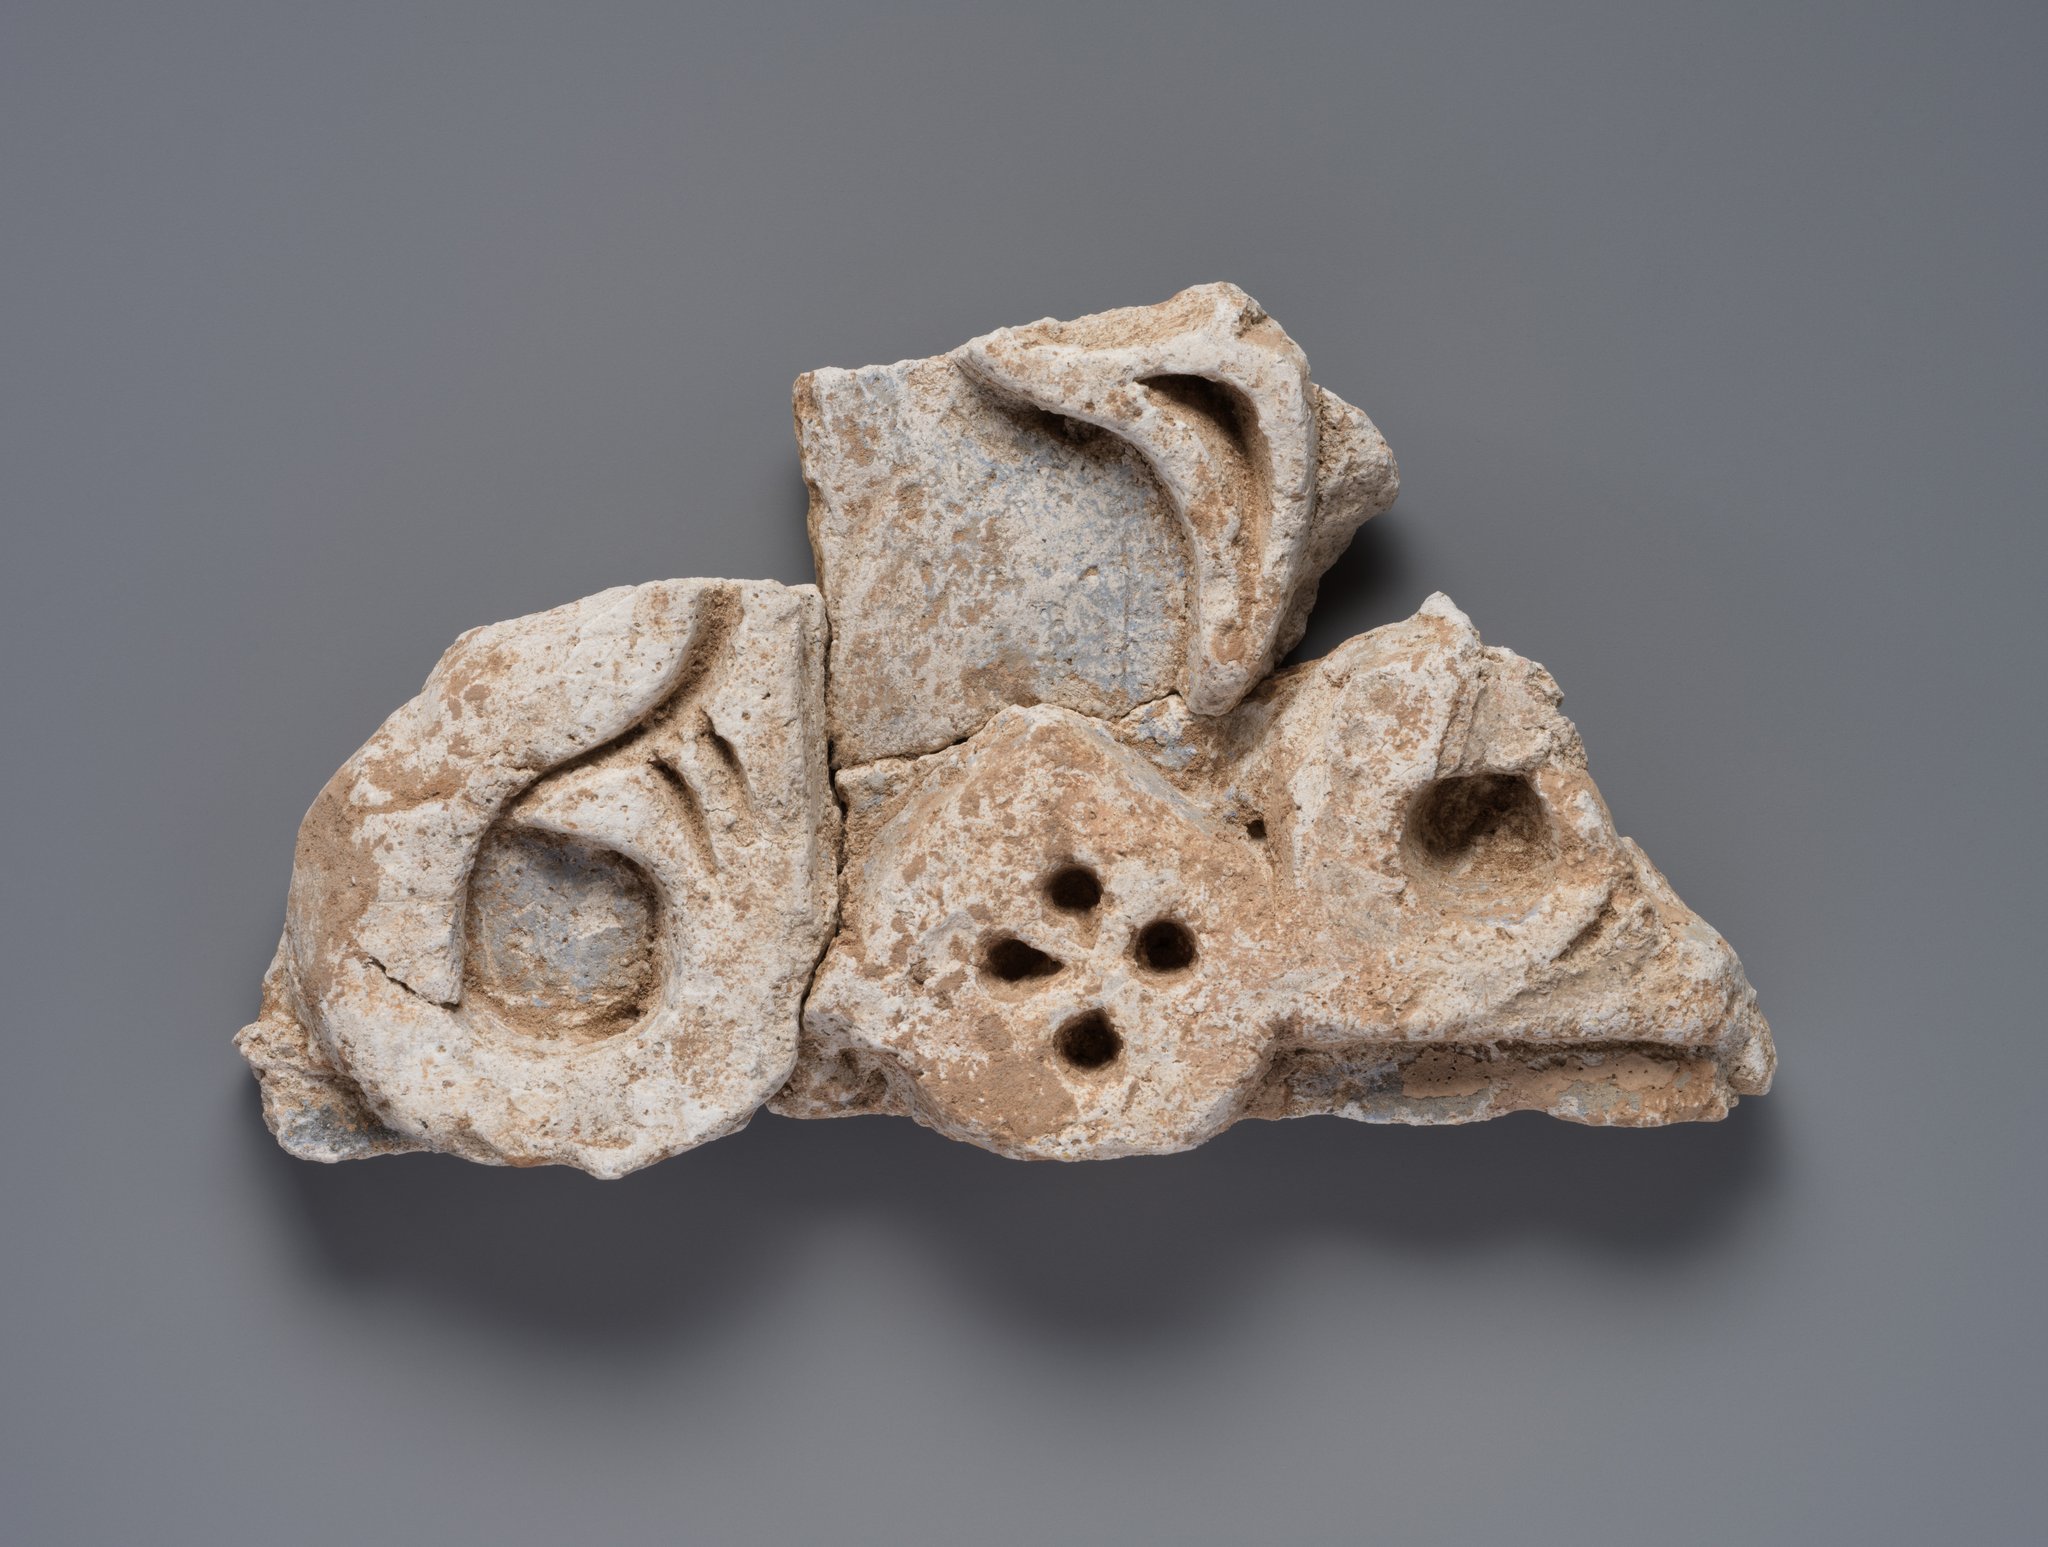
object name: fragment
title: Stucco Fragment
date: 701-1200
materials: plaster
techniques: carving, painting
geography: iran